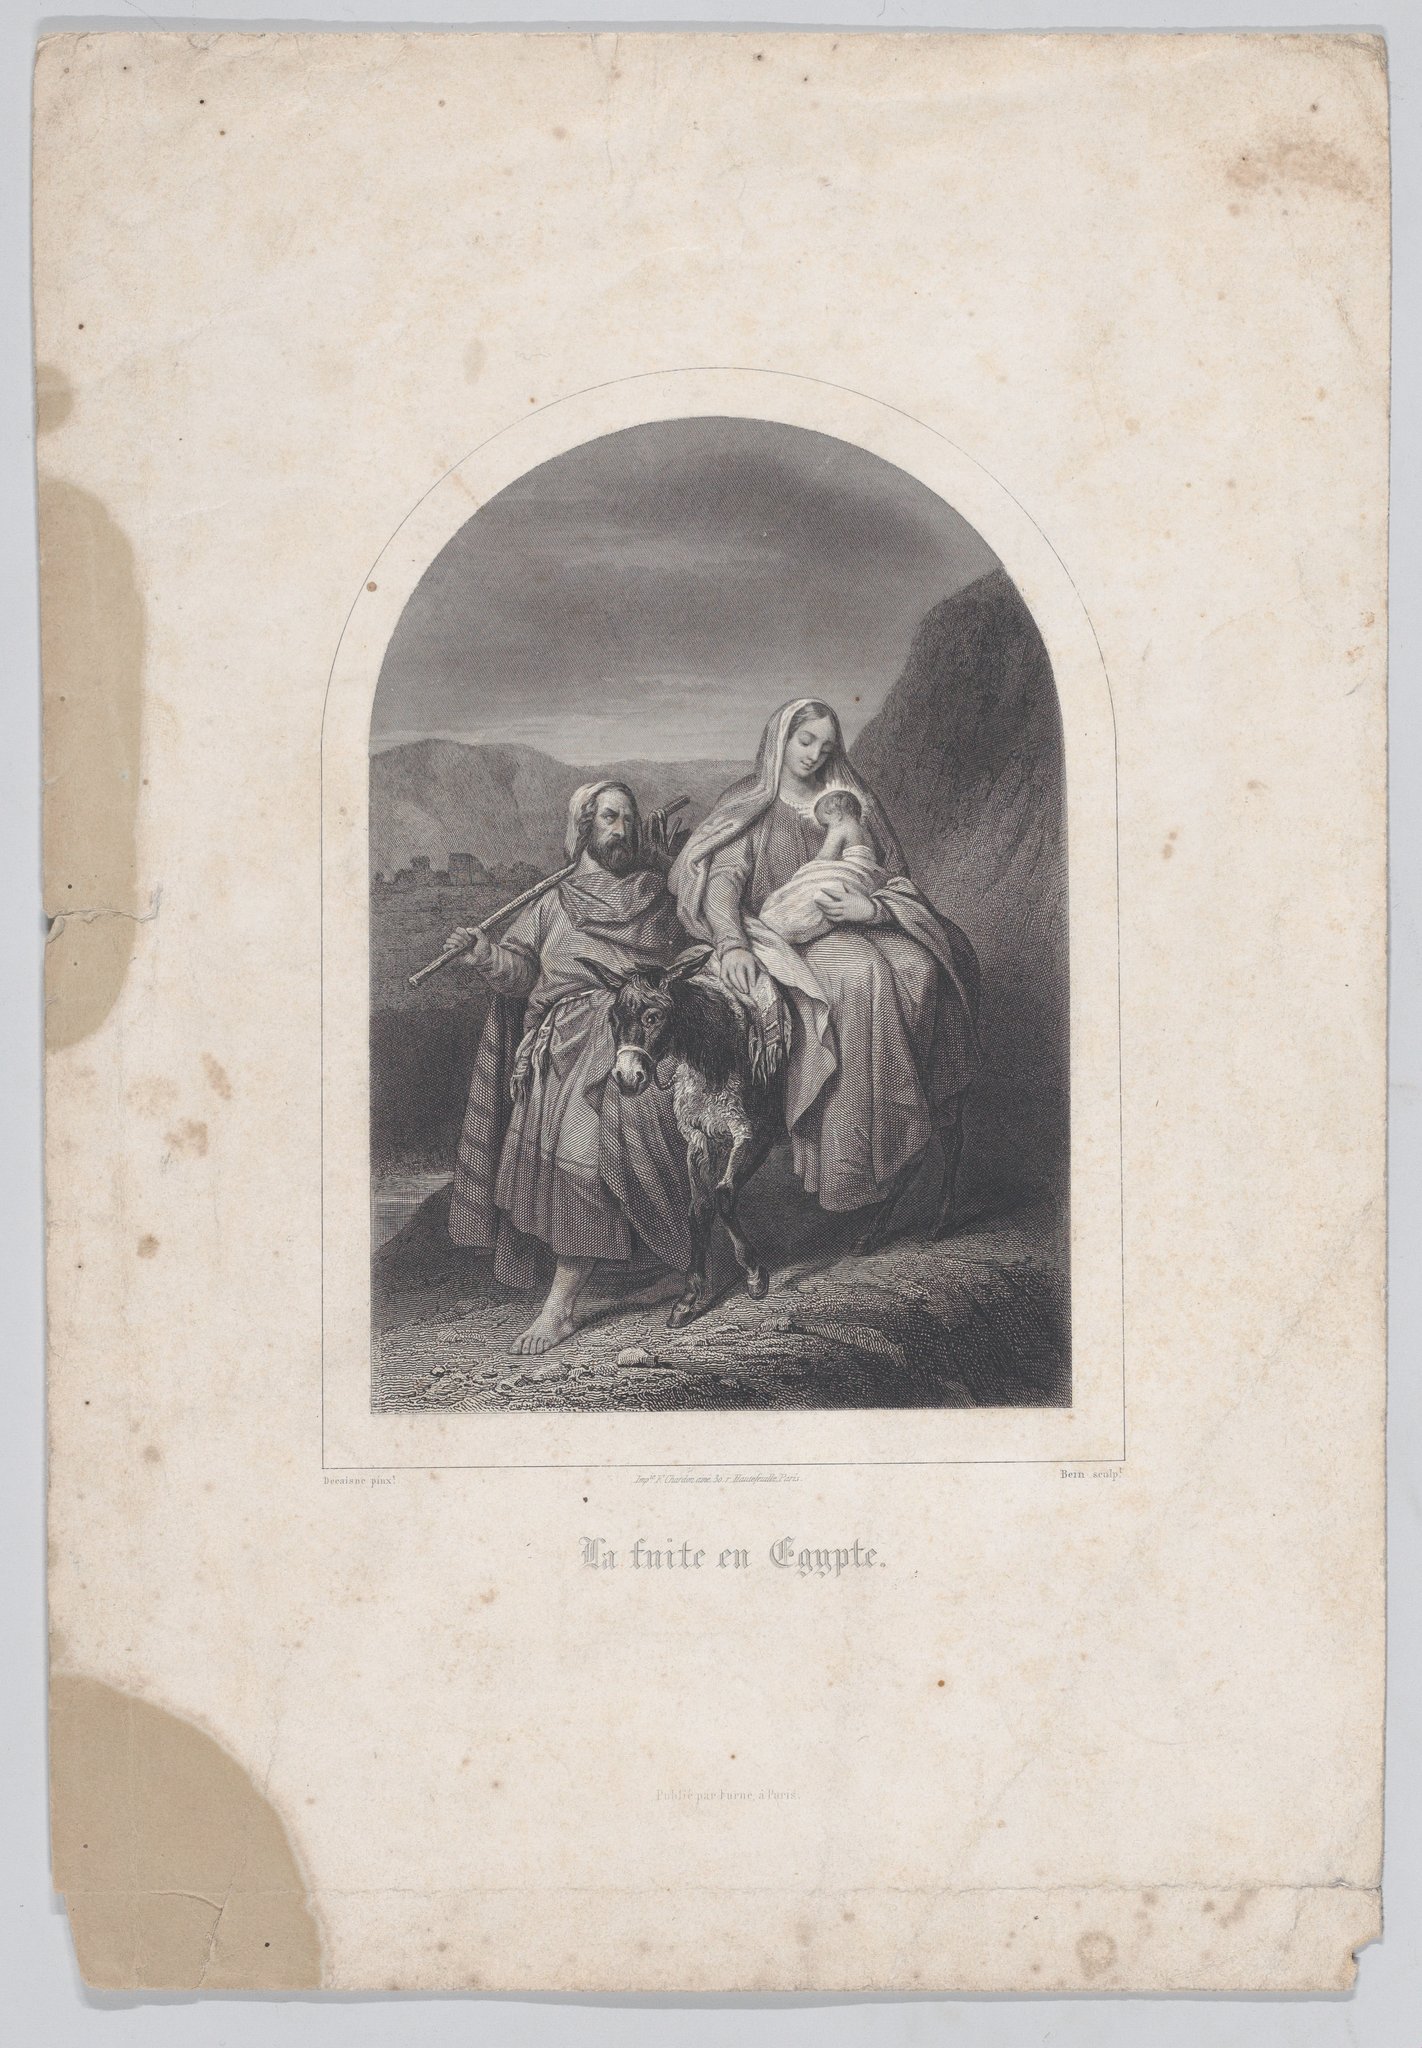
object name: print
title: The Flight into Egypt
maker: jean bein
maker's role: artist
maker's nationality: french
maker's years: 1789-1857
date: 1820-1857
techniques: engraving